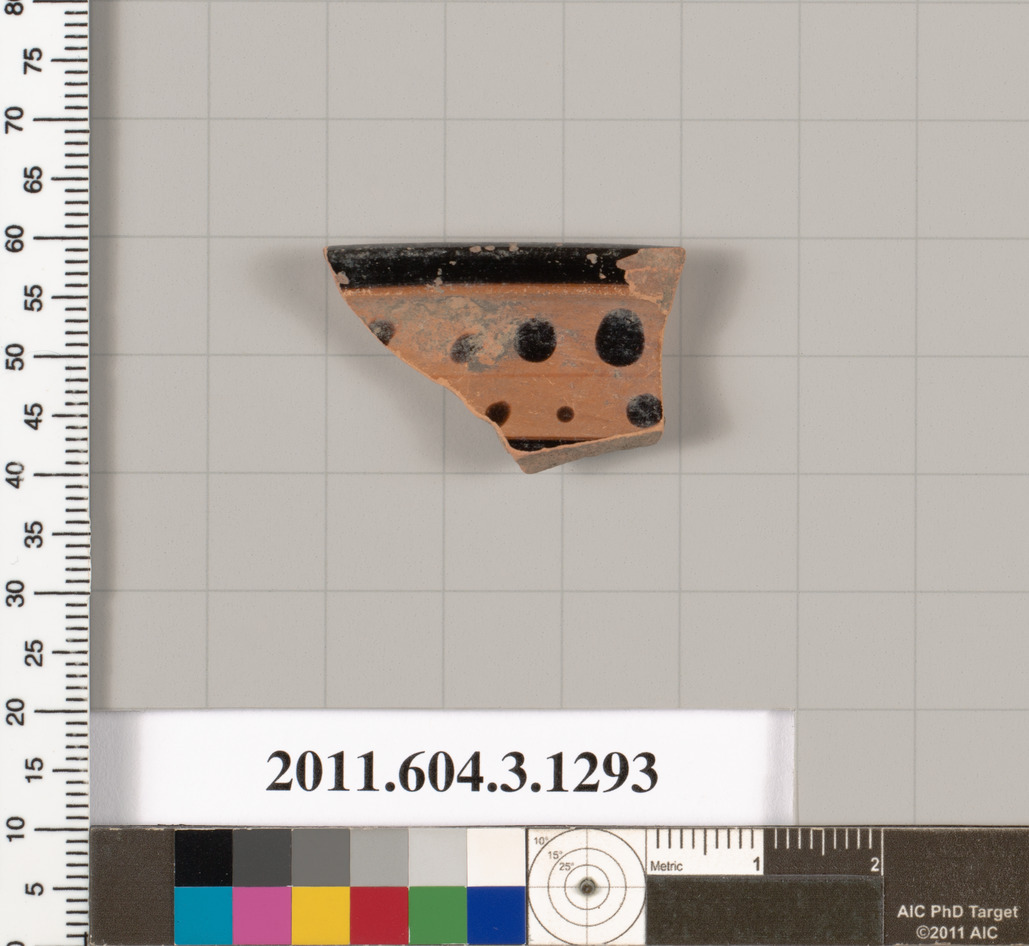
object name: skyphos fragment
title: Terracotta rim fragment of a skyphos (deep drinking cup)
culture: greek, attic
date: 500 BCE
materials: terracotta